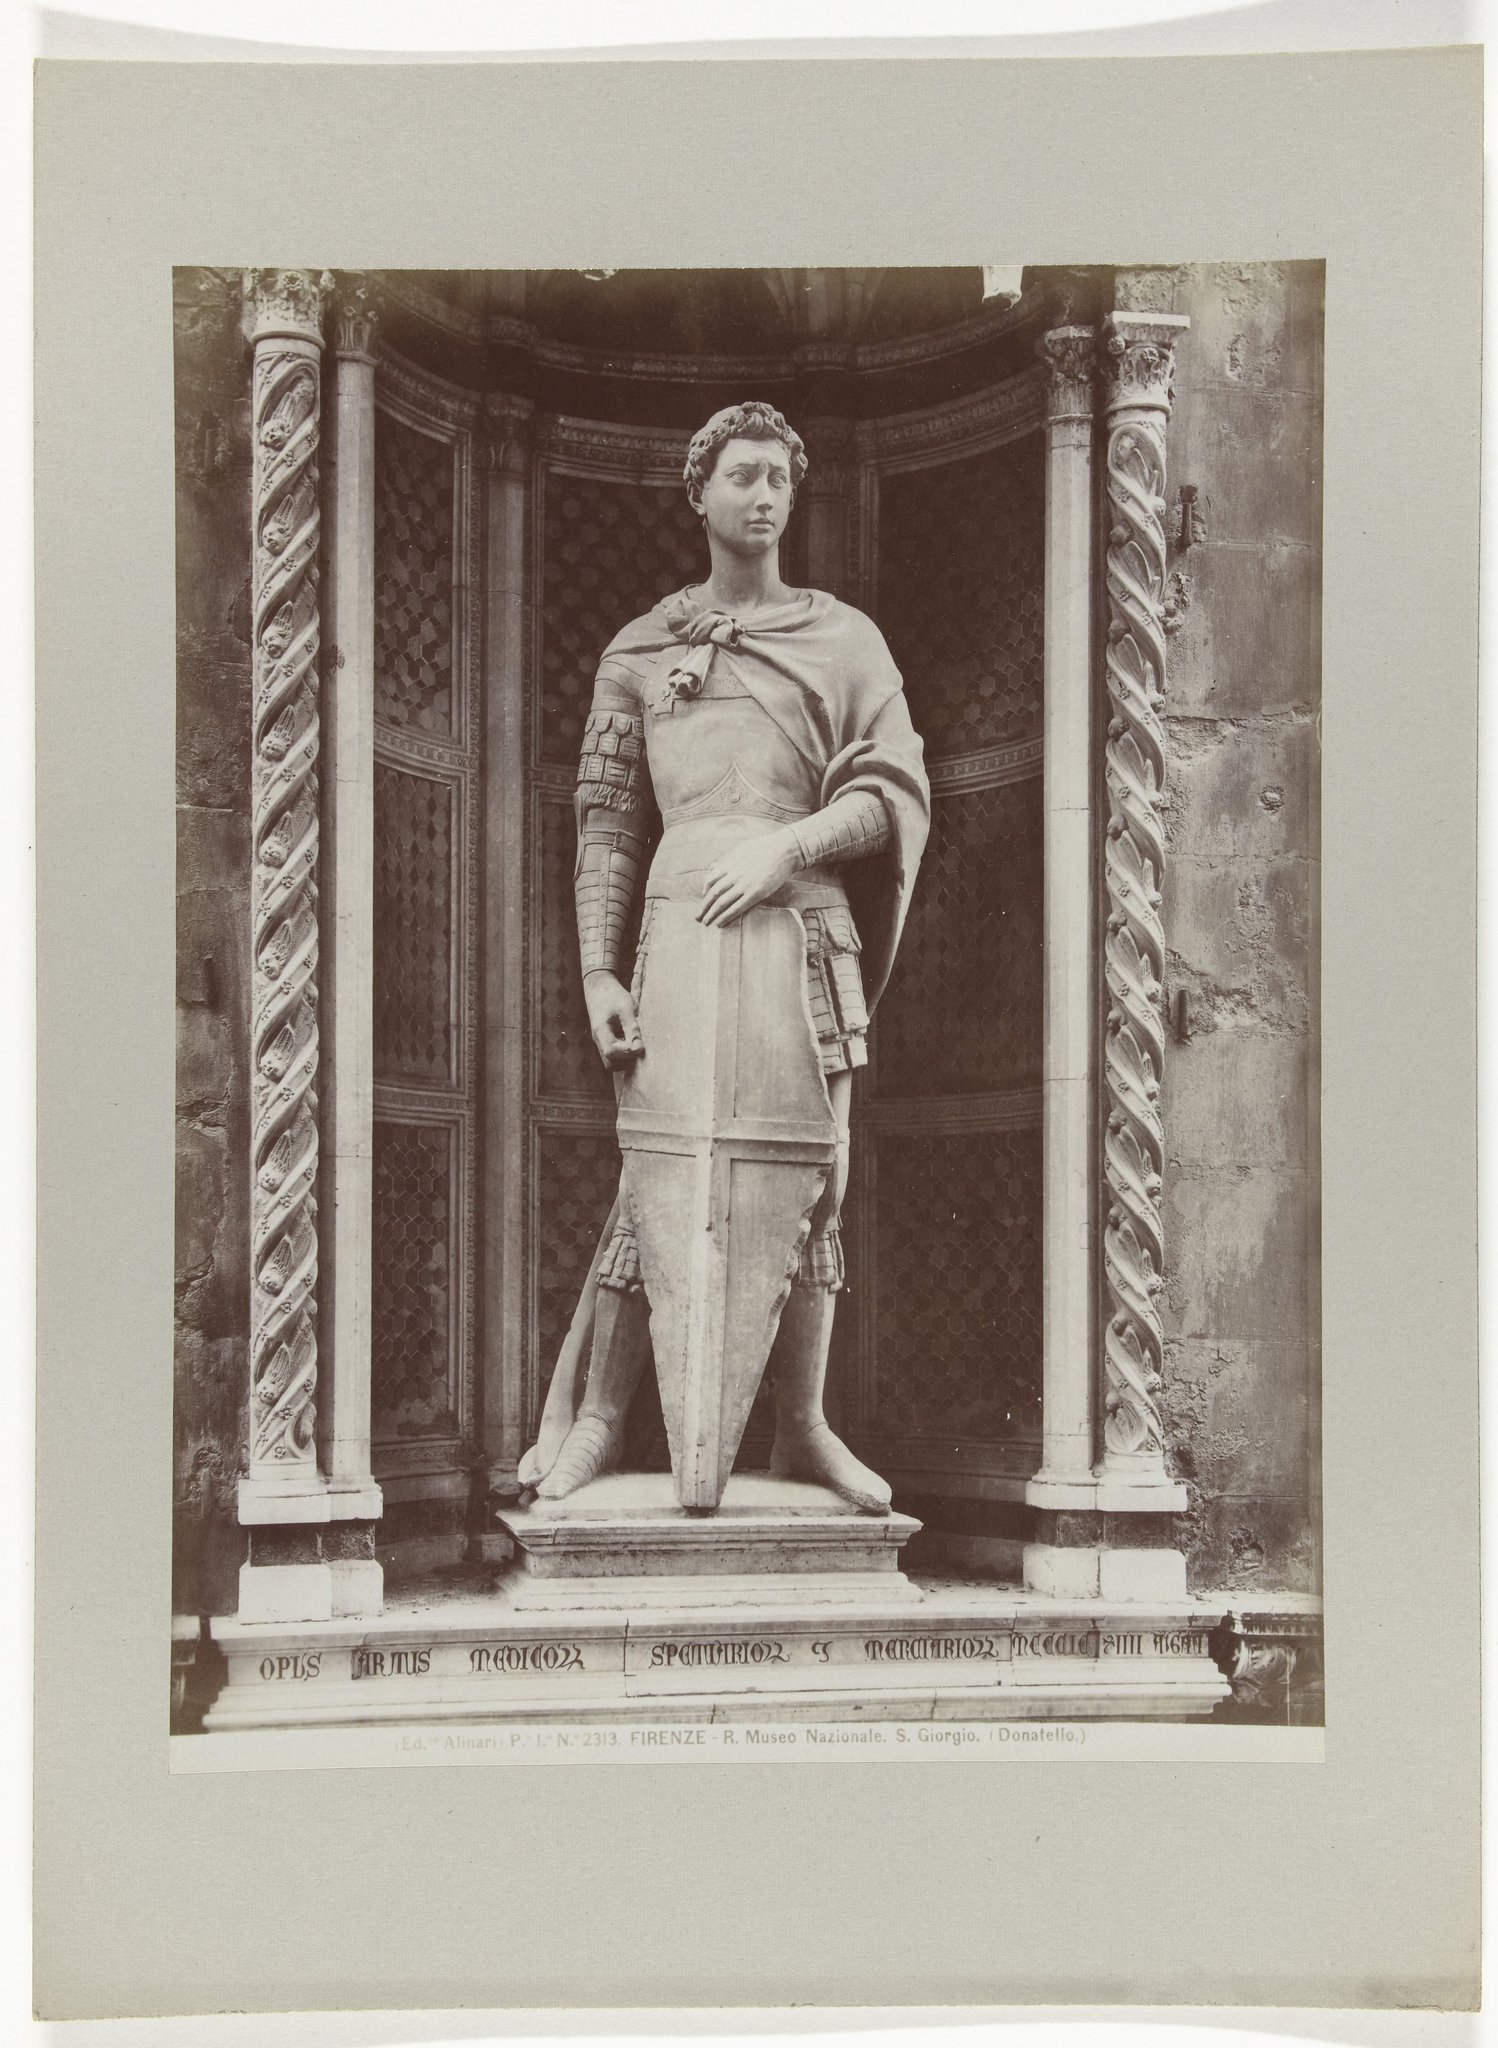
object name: photograph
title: Sculptuur van Heilige Joris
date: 1880-1895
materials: cardboard, paper, photographic support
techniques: albumen print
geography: florence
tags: piece of sculpture, reproduction of a piece of sculpture, monument, statue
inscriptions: number: ‘75.’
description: Sculptuur van de Heilige Joris te Florence, gemaakt door Donatello.